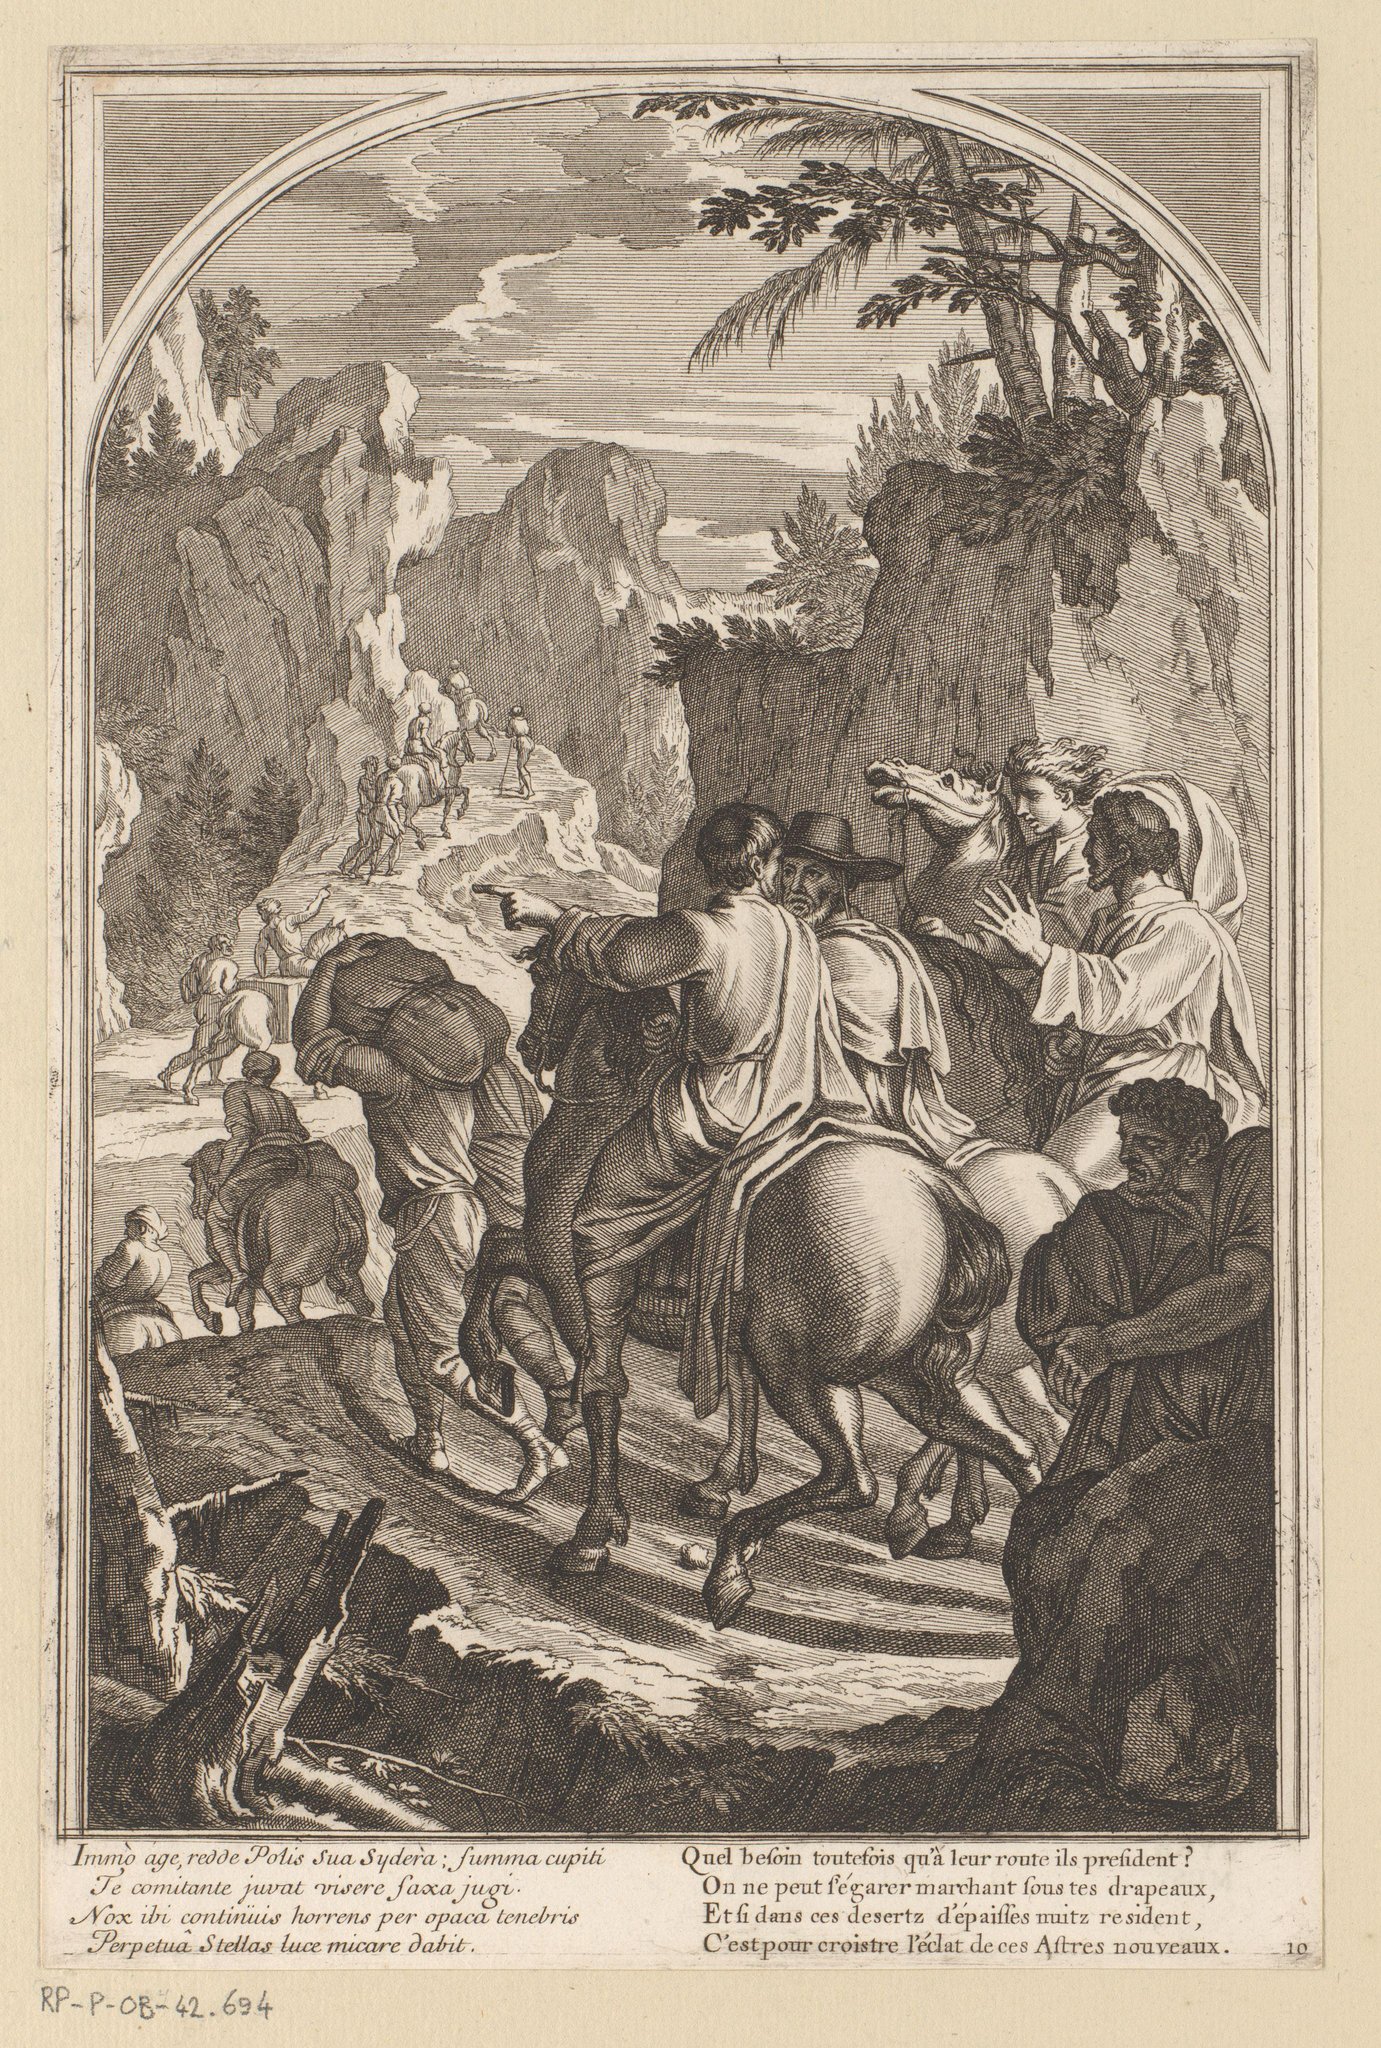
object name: print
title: Reis van de Heilige Bruno en zijn metgezellen naar la Chartreuse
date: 1623-1676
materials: paper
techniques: engraving, etching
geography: paris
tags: the founder of the order of the carthusians, bruno; possible attributes: cross, finger at lips, lily, mitre at his feet, olive-branch, ray of light, skull, (seven) star(s), personal devotion of st. bruno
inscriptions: collector's mark: Lugt 2165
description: Maakt deel uit van een serie met 24 prenten (inclusief twee titelprenten), naar schilderijen door Lesueur vervaardigd tussen 1645-1648 voor de Chartreuse de Paris. De serie is getiteld: La vie de St. Bruno fondateur de l'Ordre des Chartreux peinte au cloistre de la Chartreuse de Paris par Eustache Le Sueur.